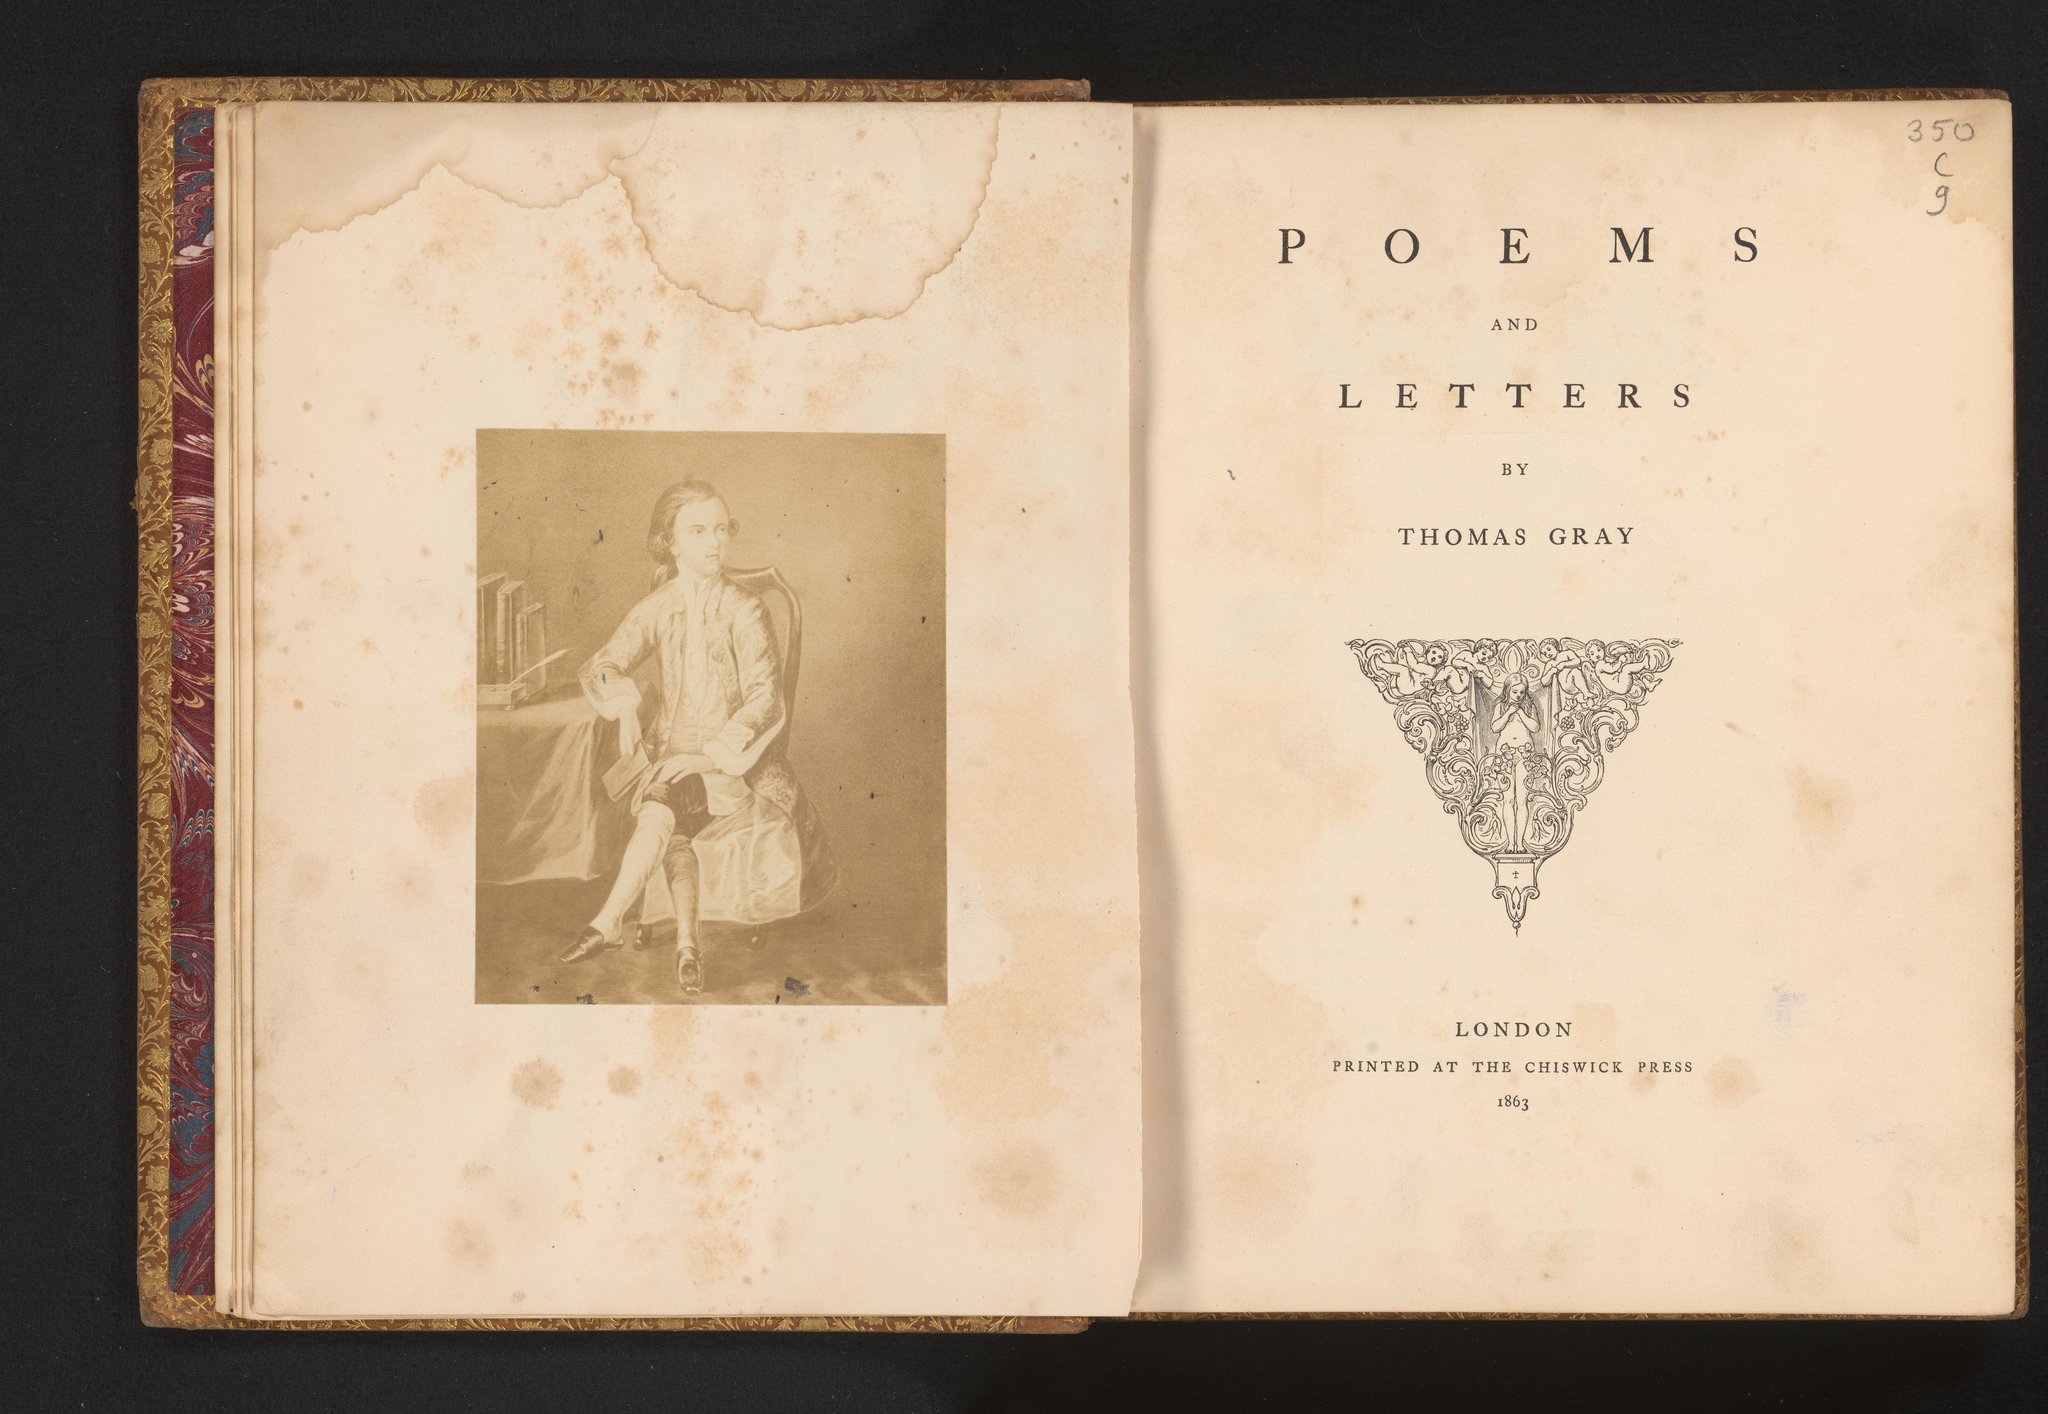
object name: reproduction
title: Fotoreproductie van een geschilderd portret van Thomas Gray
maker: Anonymous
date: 1859-1863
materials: paper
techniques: albumen print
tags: thomas gray, portrait of a writer